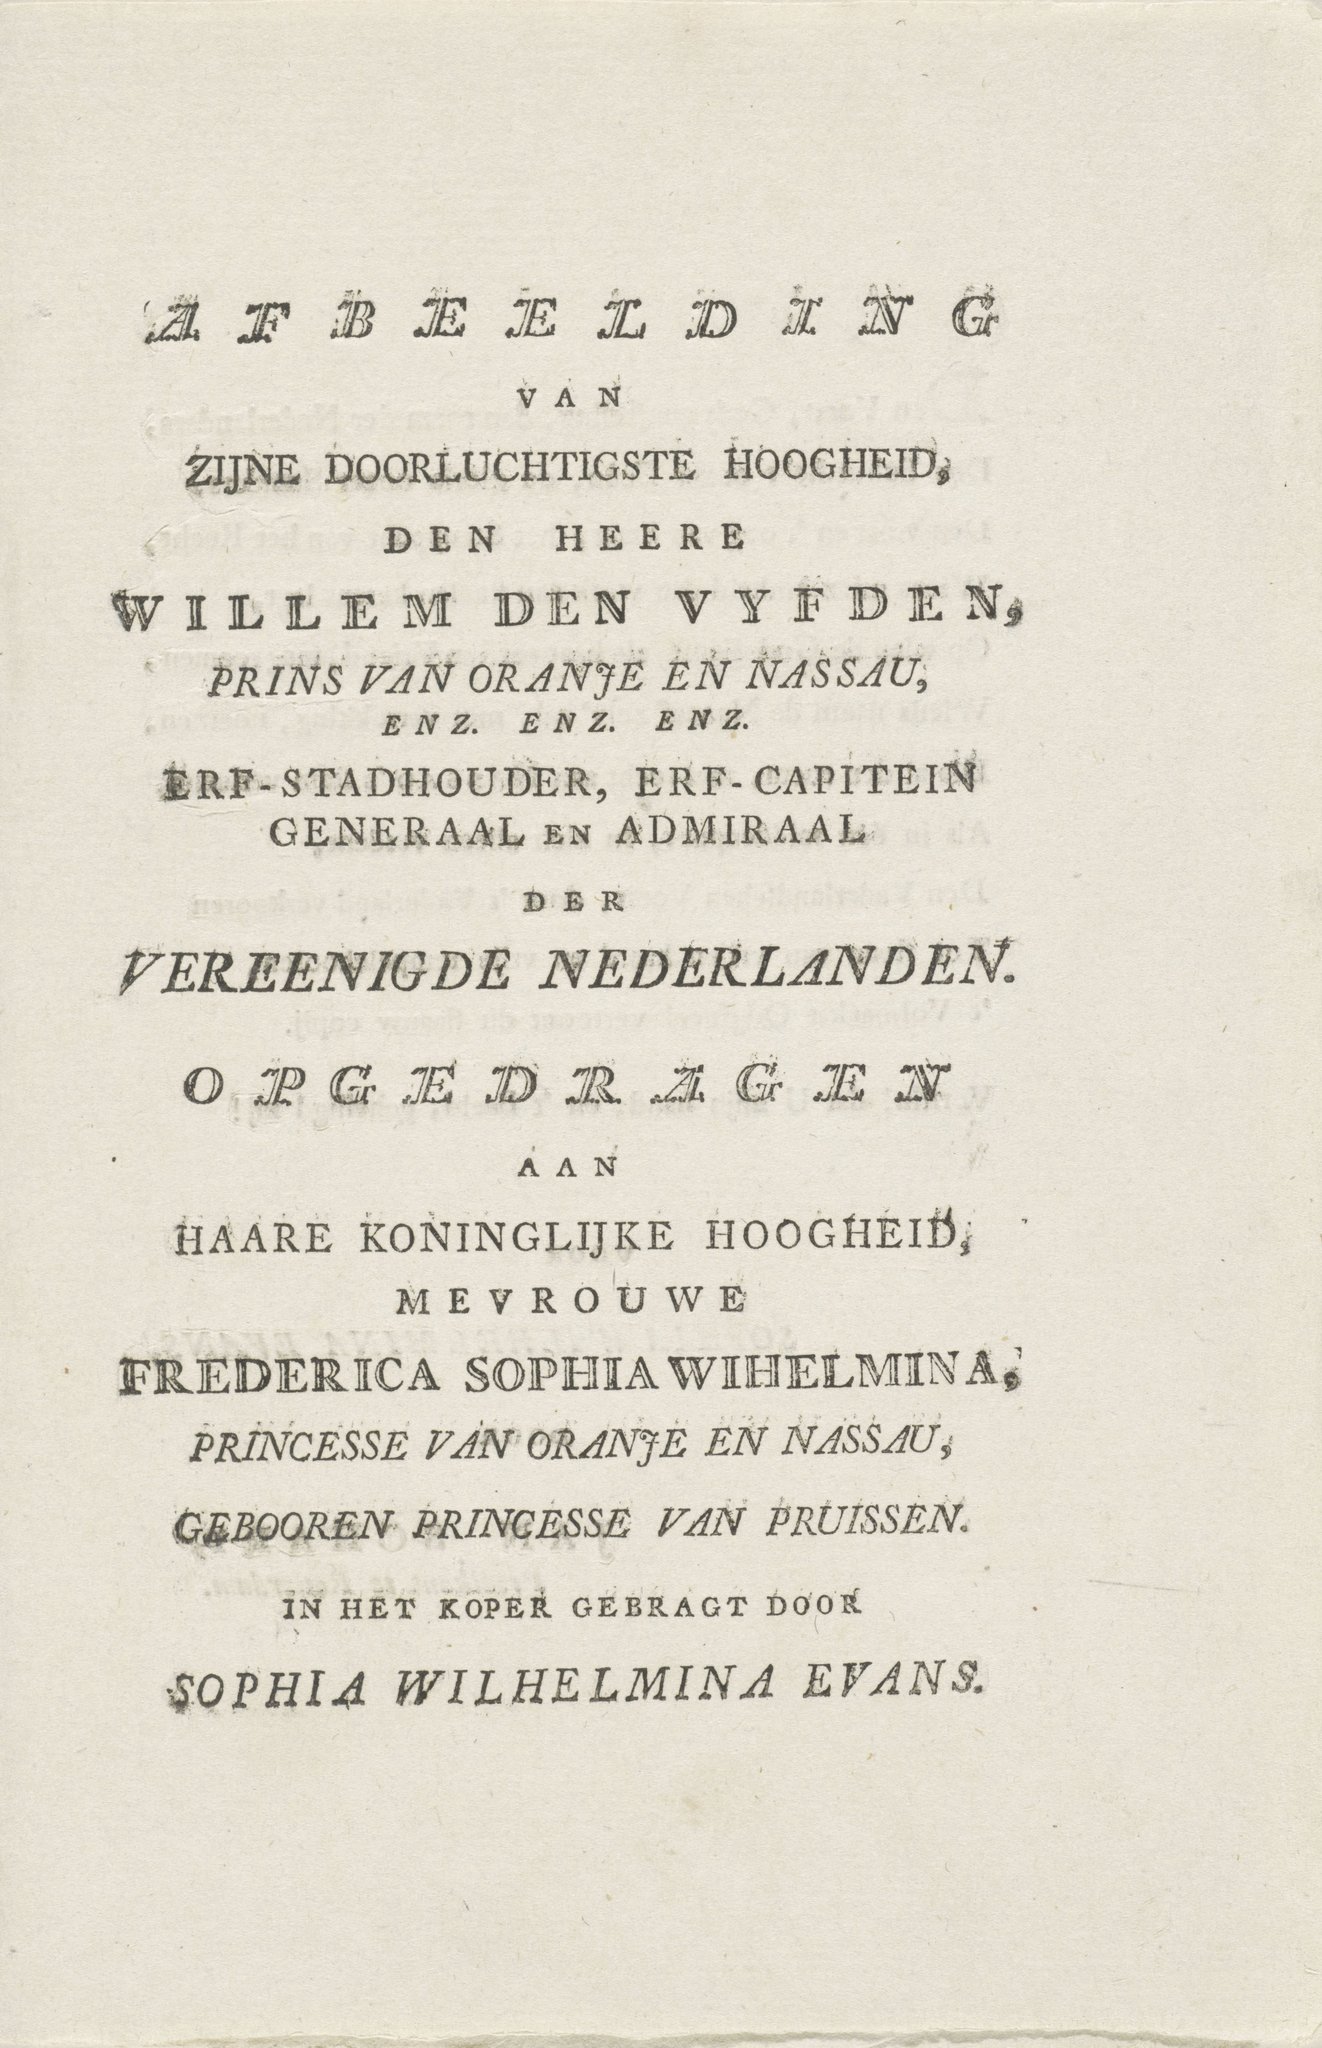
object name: text sheet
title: Tekst bij het portret van Willem V, prins van Oranje-Nassau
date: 1787-1816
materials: paper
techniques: letterpress printing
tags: the hague, william v (prince of orange)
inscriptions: collector's mark: Lugt 2228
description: De hier vermelde titel verwijst naar de hoogst verkregen titel van de geportretteerde, niet per se naar de titel die de geportretteerde op deze voorstelling draagt.